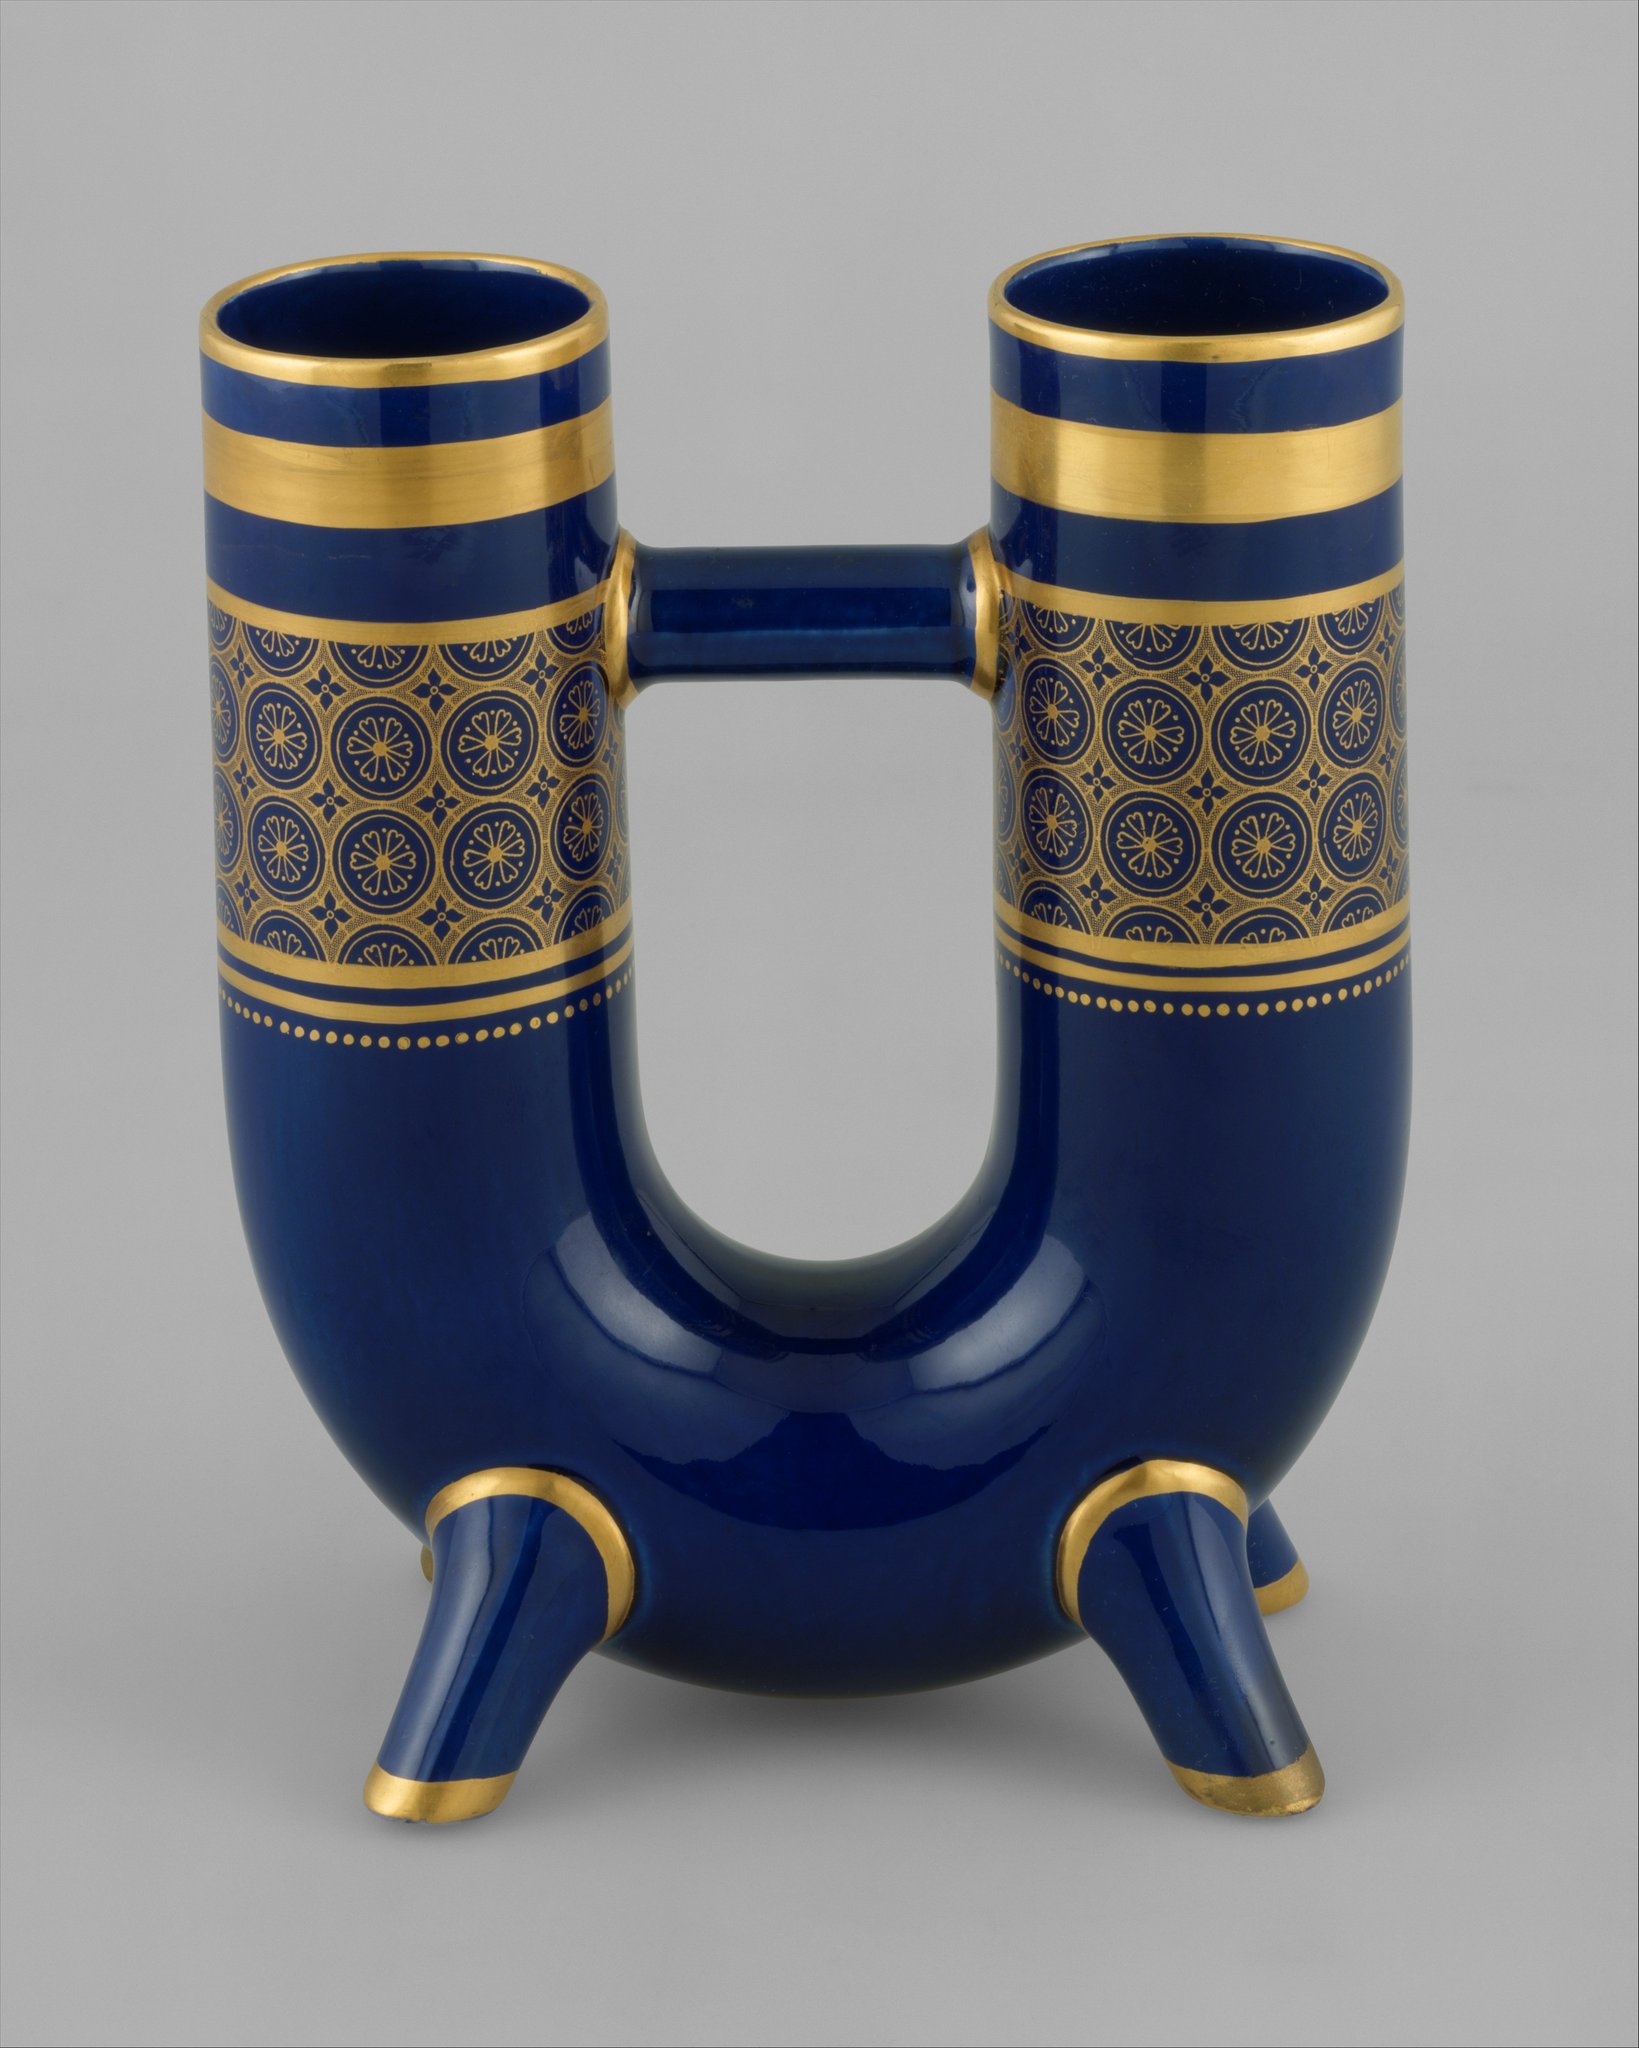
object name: vase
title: U-shaped vase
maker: minton(s)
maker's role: factory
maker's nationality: british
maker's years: 1793-2001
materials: hard paste porcelain